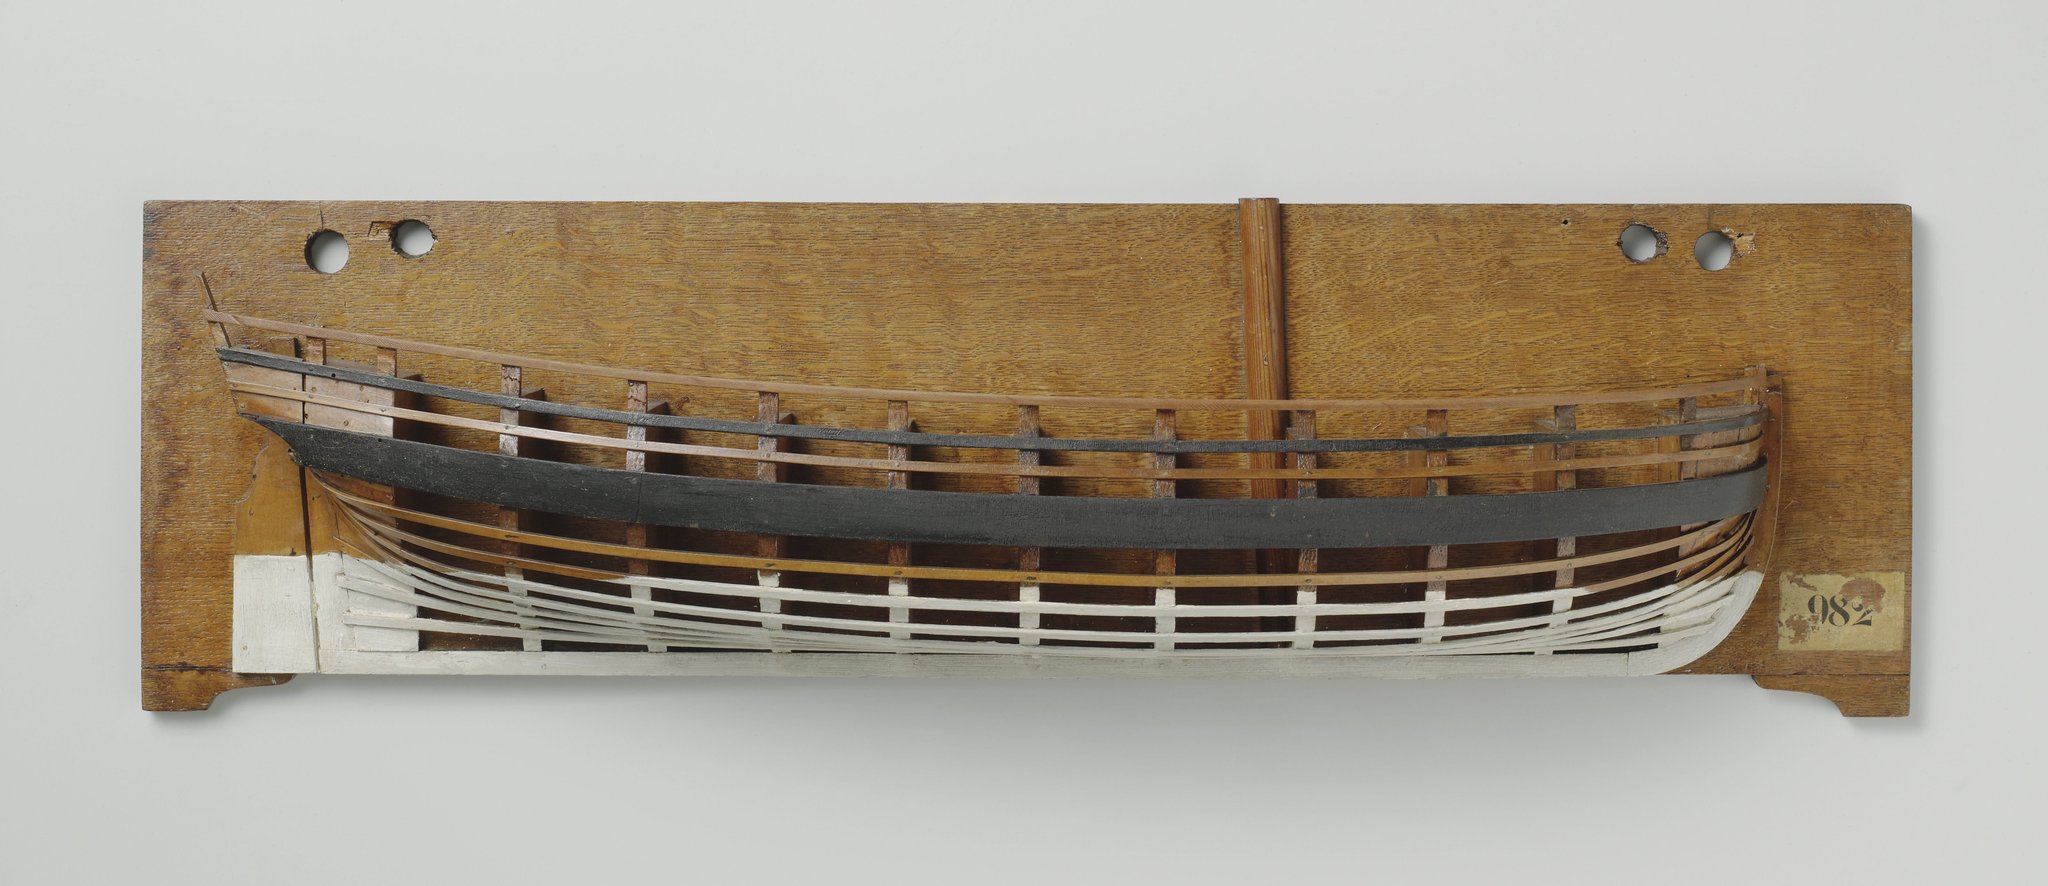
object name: builder's model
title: Half Model of a Schooner Gunboat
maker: Anonymous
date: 1780-1820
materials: wood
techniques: polychromy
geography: netherlands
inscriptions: label, bottom right: ‘402’ former inventory label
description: Dit model draagt nummer 982, wat een visschuit lang 44 voet zou moeten zijn, en het model met nummer 402 is die visschuit, zodat het lijkt dat beide modellen verwisseld zijn. NG-MC-402 moet een kanonneerschoener uit 1792 zijn, gebouwd in Amsterdam.